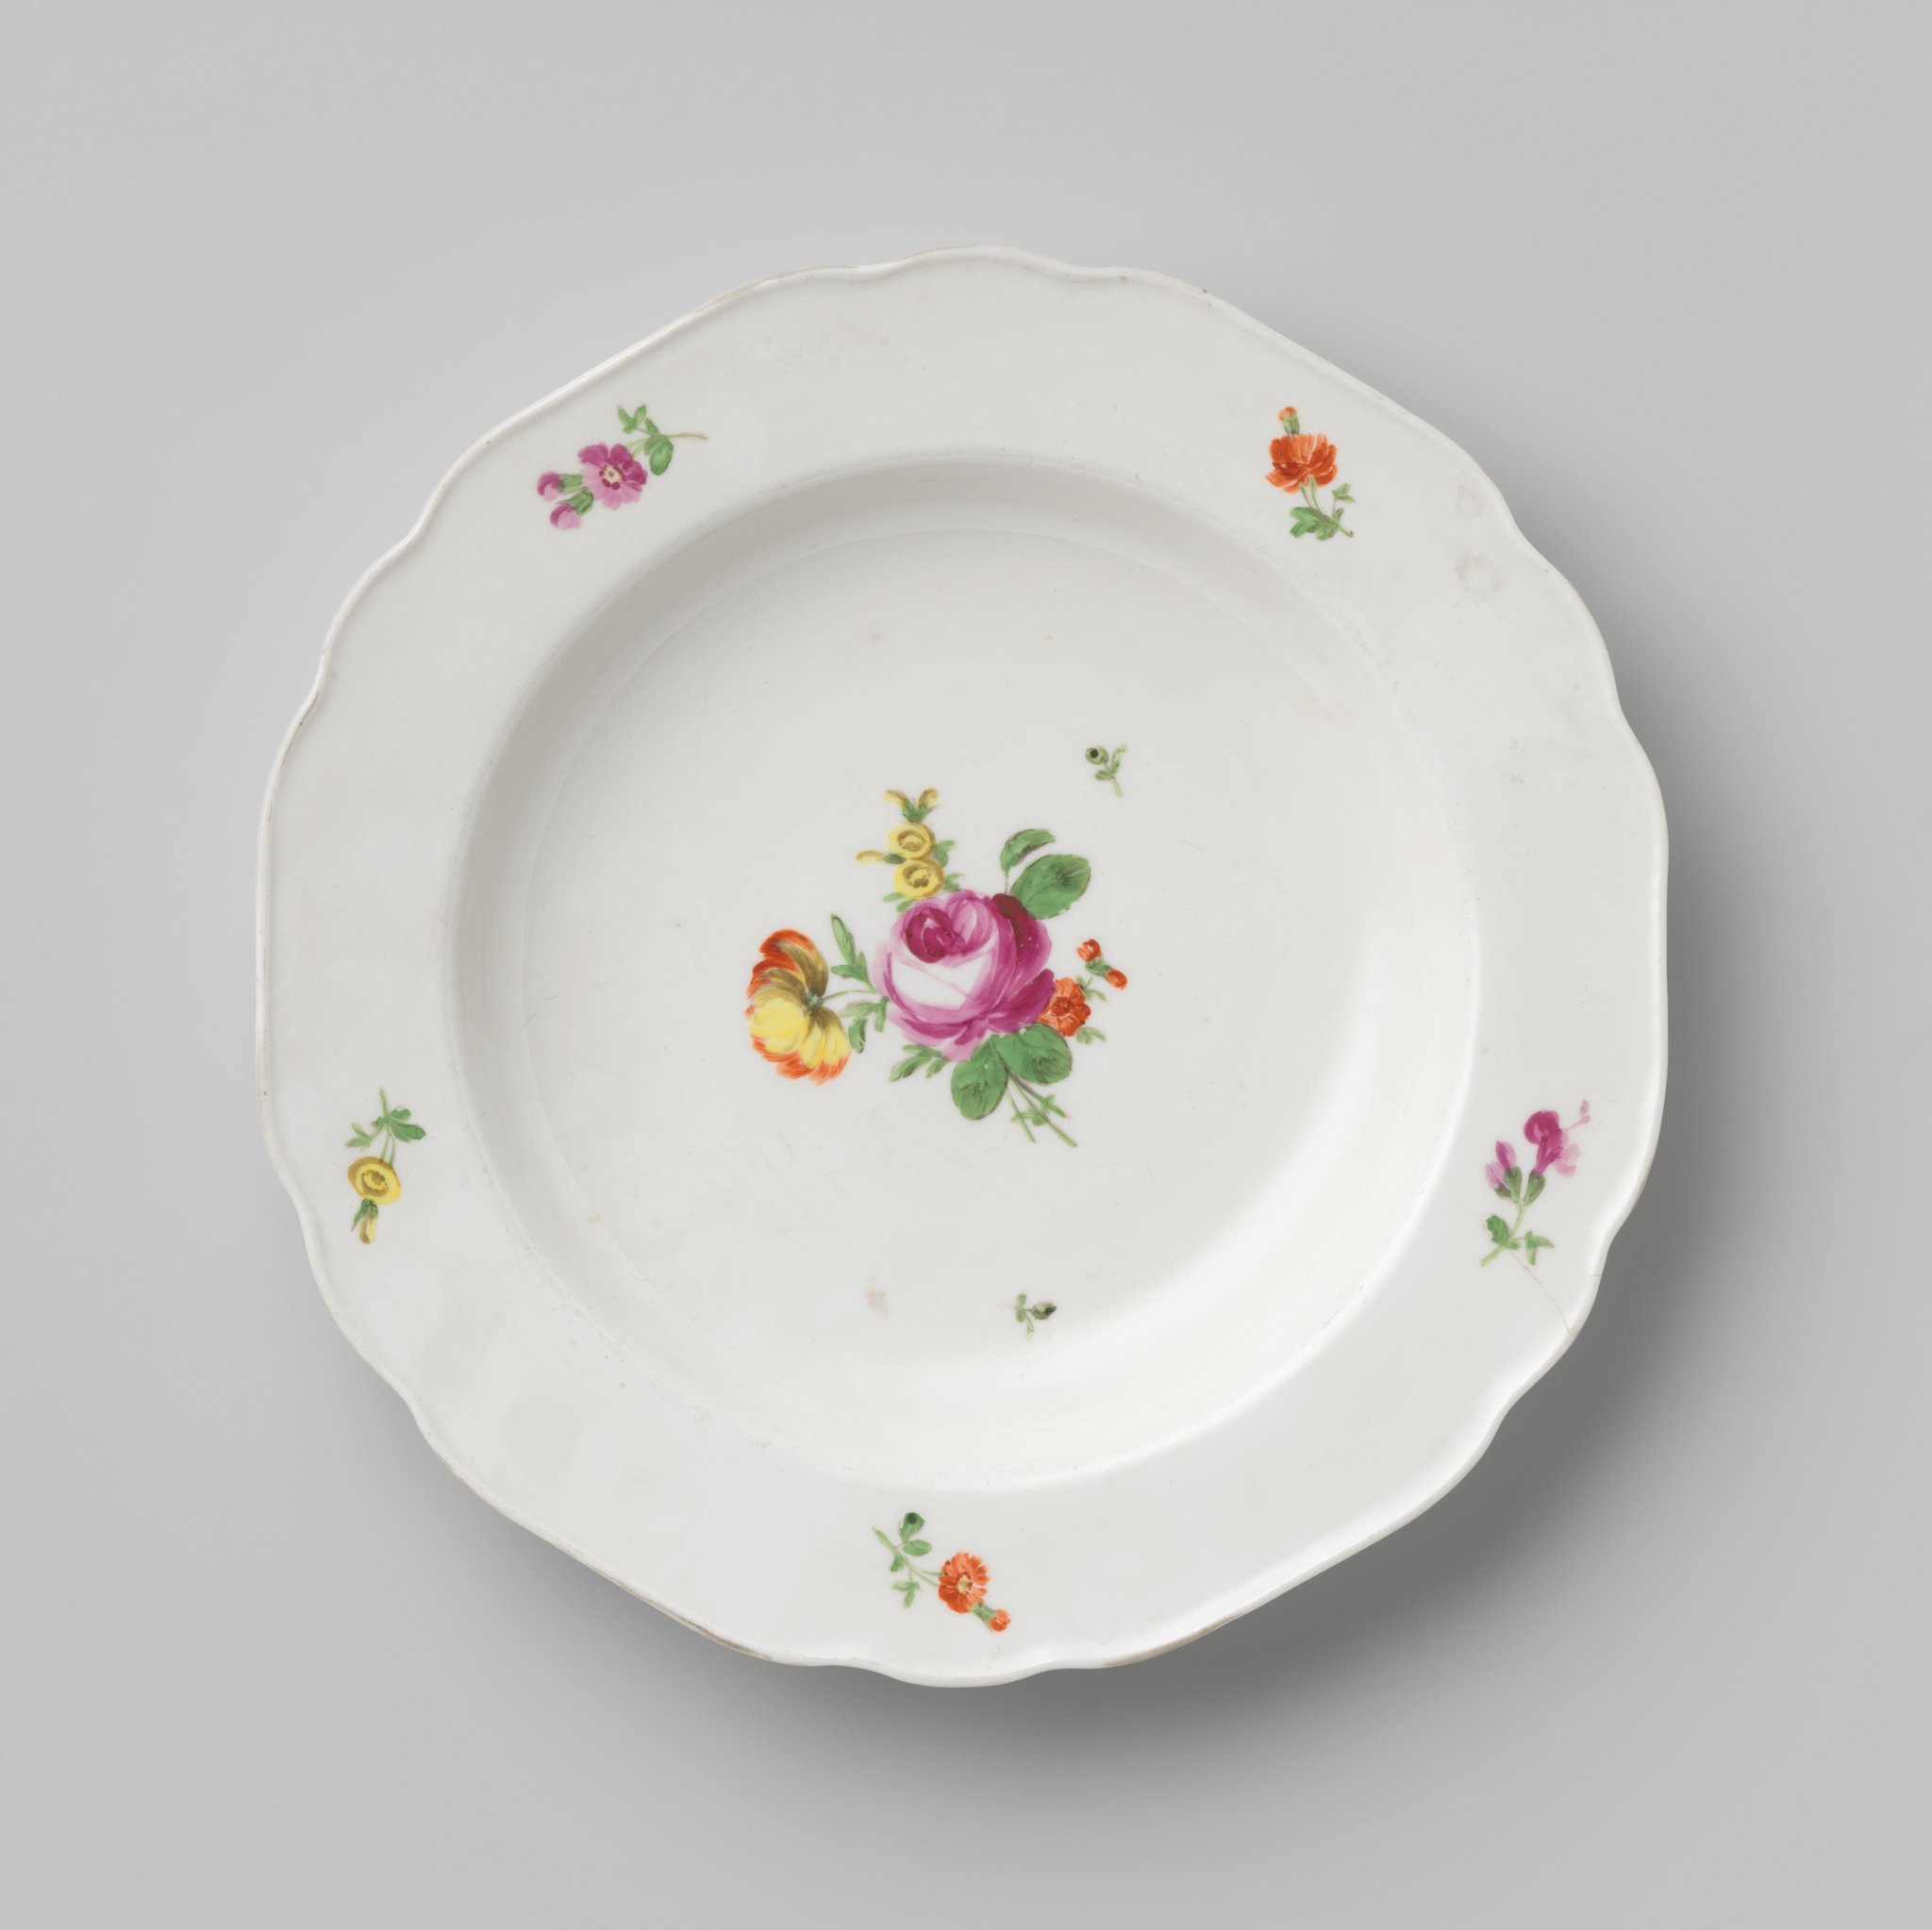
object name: service set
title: Plate with a bouquet and flower sprays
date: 1800-1849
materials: glaze, paint, porcelain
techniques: firing, forming, turning, vitrification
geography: vienna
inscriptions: mark: ‘schild/ P/ S/ 32/ 11/ 89’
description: Bord van porselein met een gelobde rand, beschilderd op het glazuur in rood, roze, groen en geel. Op het plat een boeket van verschillende bloemen (o.a. pioenroos) omgeven door losse takjes en op de rand vijf bloemtakken. Gemerkt op de onderzijde met het schild, de letters P en S en de nummers 32, 11 en 89.